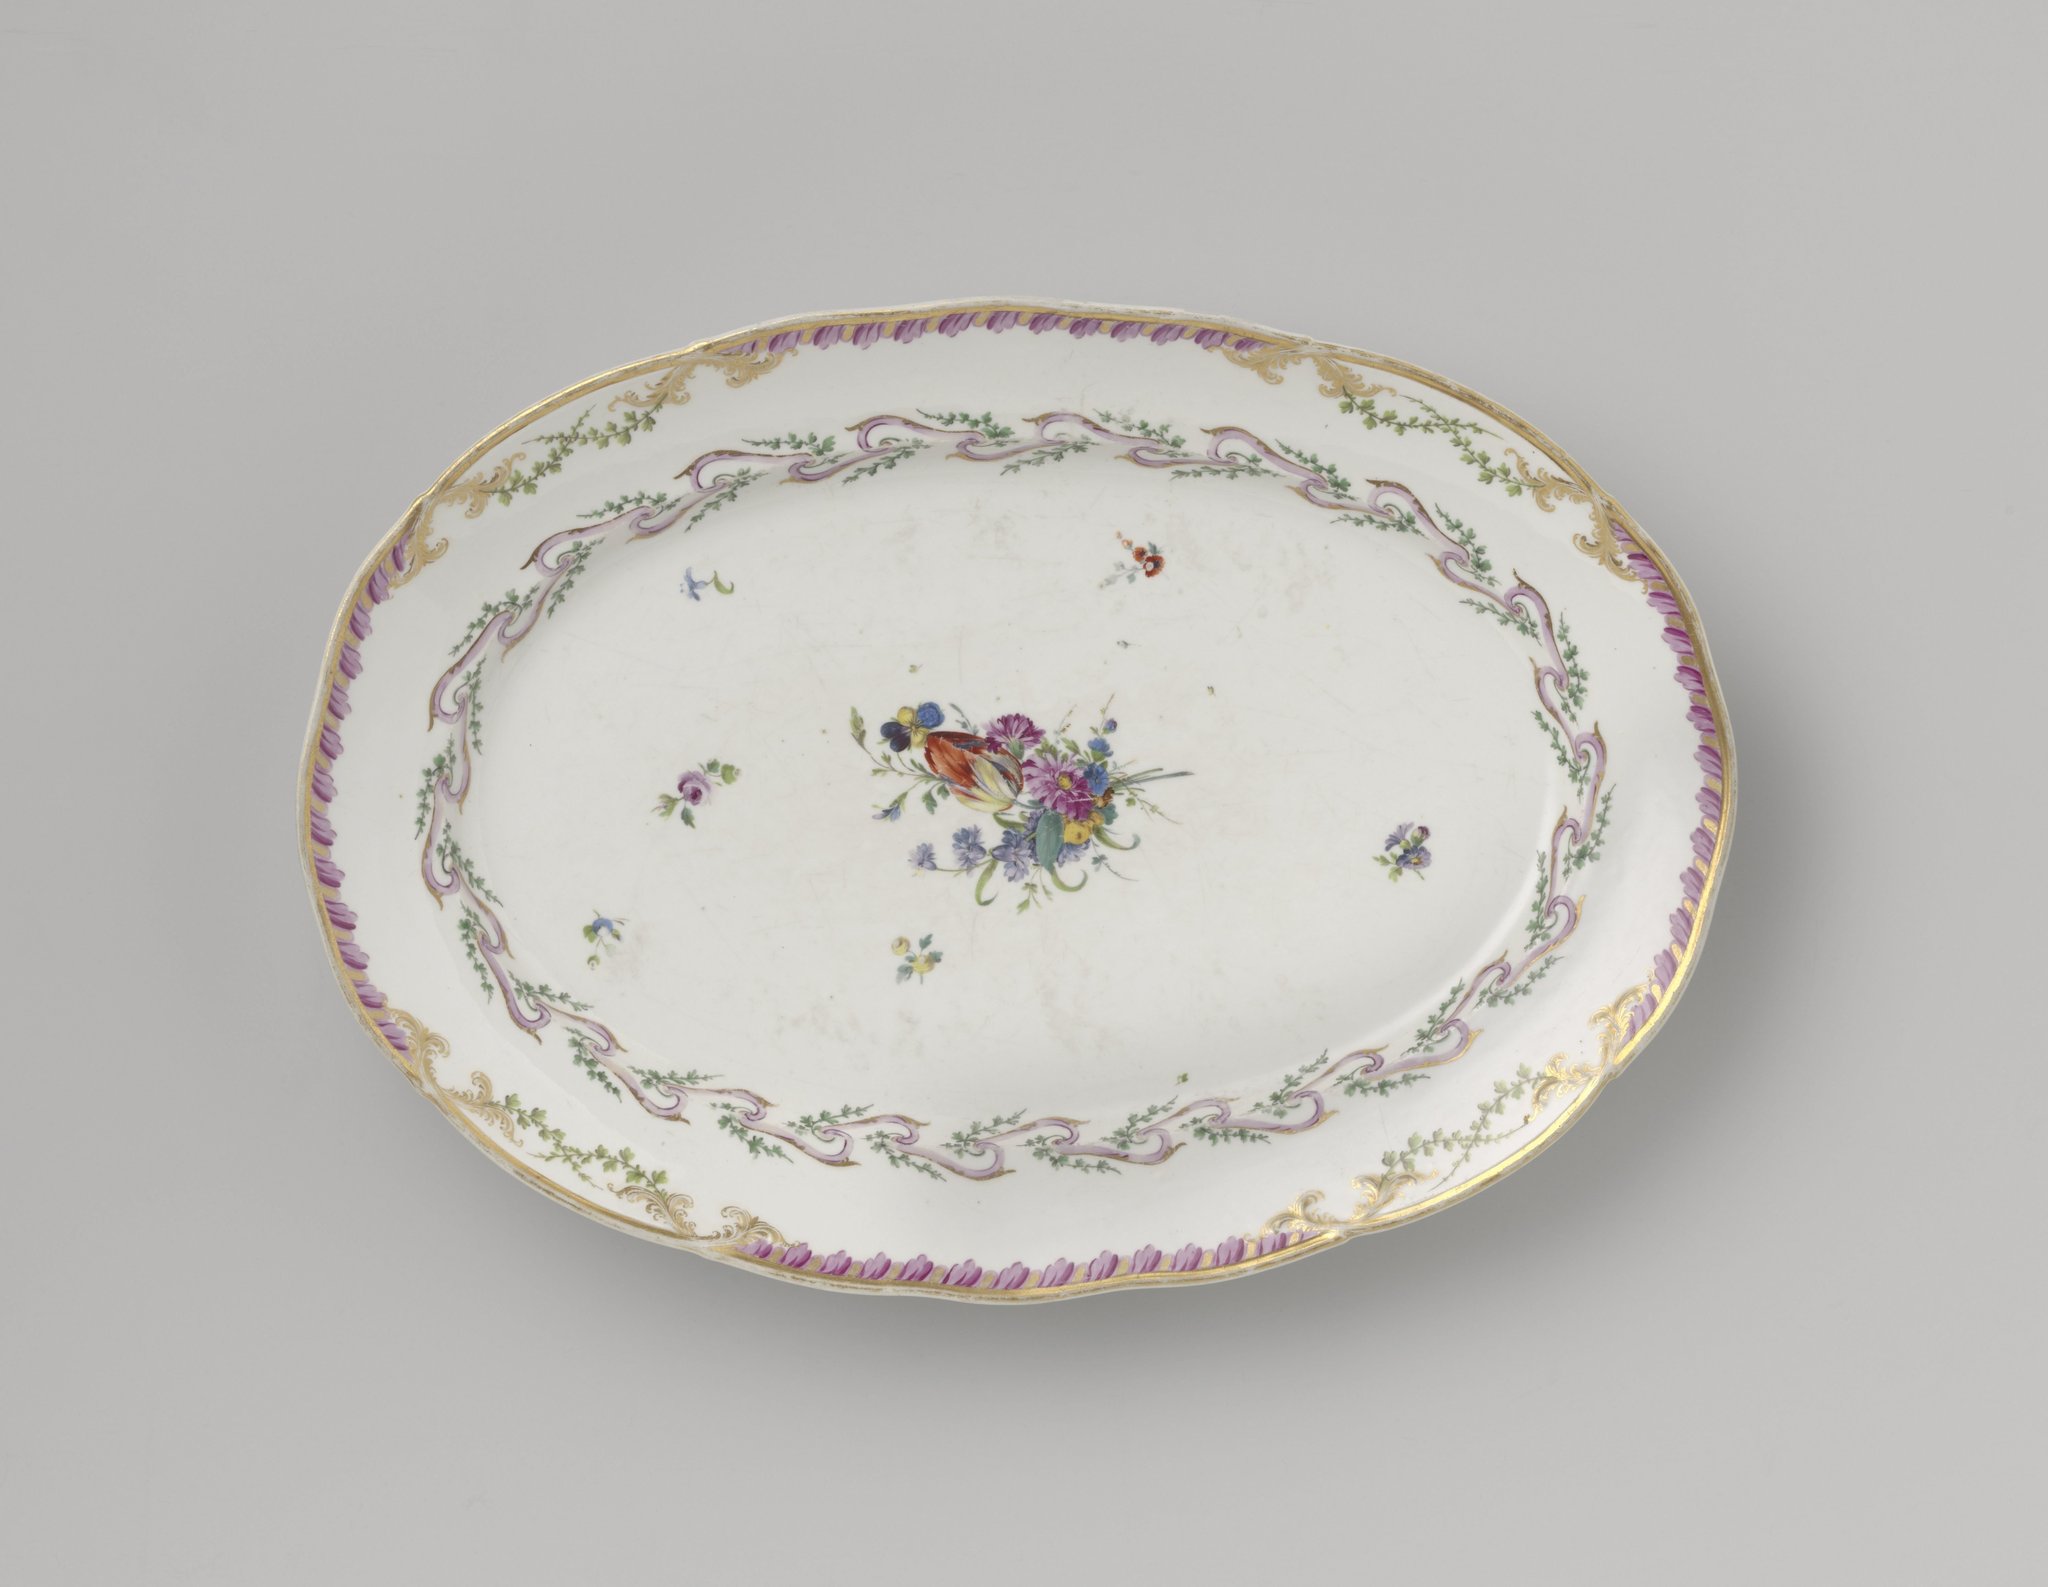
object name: platter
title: Schotel, plat en ovaal van vorm,behorend bij een servies met geslingerd lintmotief met bladertakken, bloemboeketten en gestrooide bloemtakken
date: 1780-1820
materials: porcelain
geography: loosdrecht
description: Schotel, plat en ovaal van vorm, behorend bij een servies van porselein, versierd met een geslingerd lintmotief in paars en goud met groene bladertakken, bloemboeketten en gestrooide bloemtakken. Randen lichtgegolfd met decoratie in goud met paars bladmotief waartussen groen gekruist bladmotief. Gemerkt: M.O.L. en Amstel.